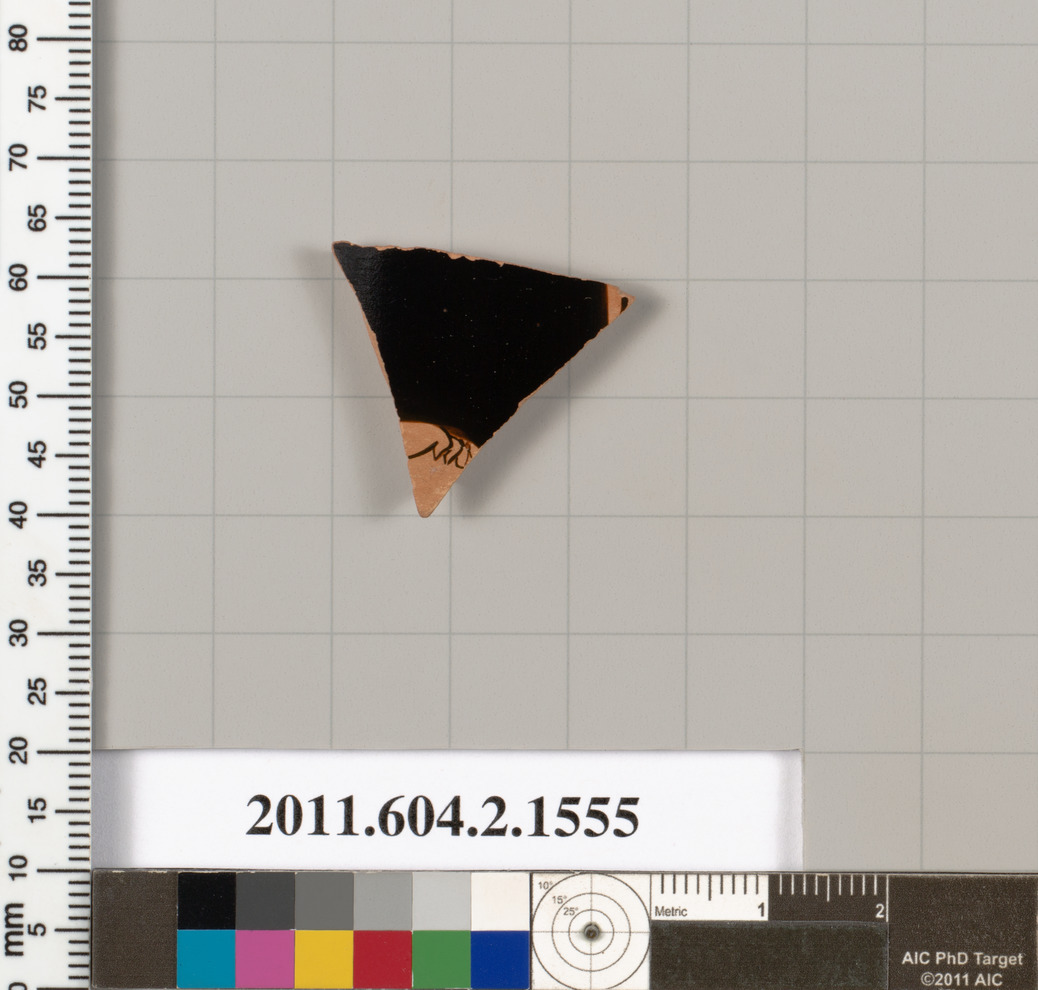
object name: skyphos fragment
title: Terracotta fragment of a skyphos (deep drinking cup)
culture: greek, attic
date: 460-440 BCE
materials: terracotta